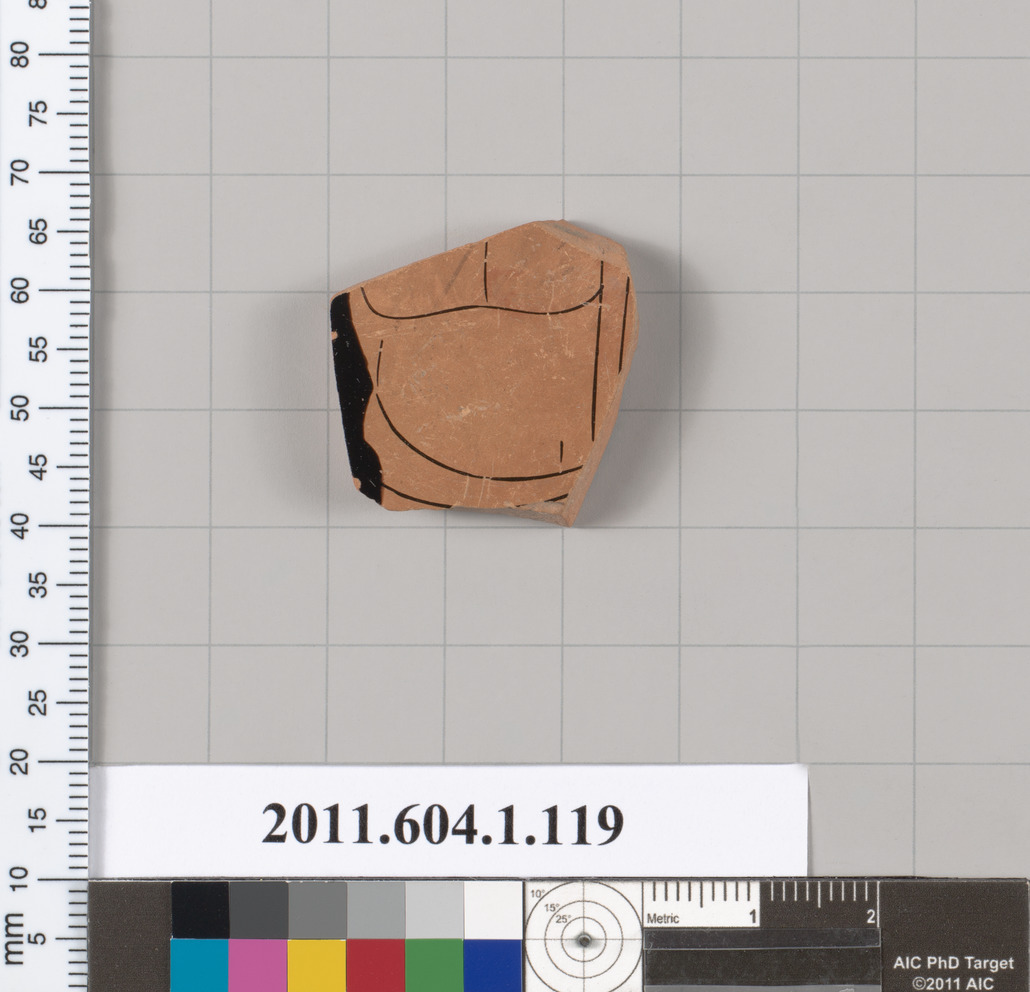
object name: kylix fragment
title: Terracotta fragment of a kylix (drinking cup)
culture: greek, attic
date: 470-450 BCE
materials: terracotta